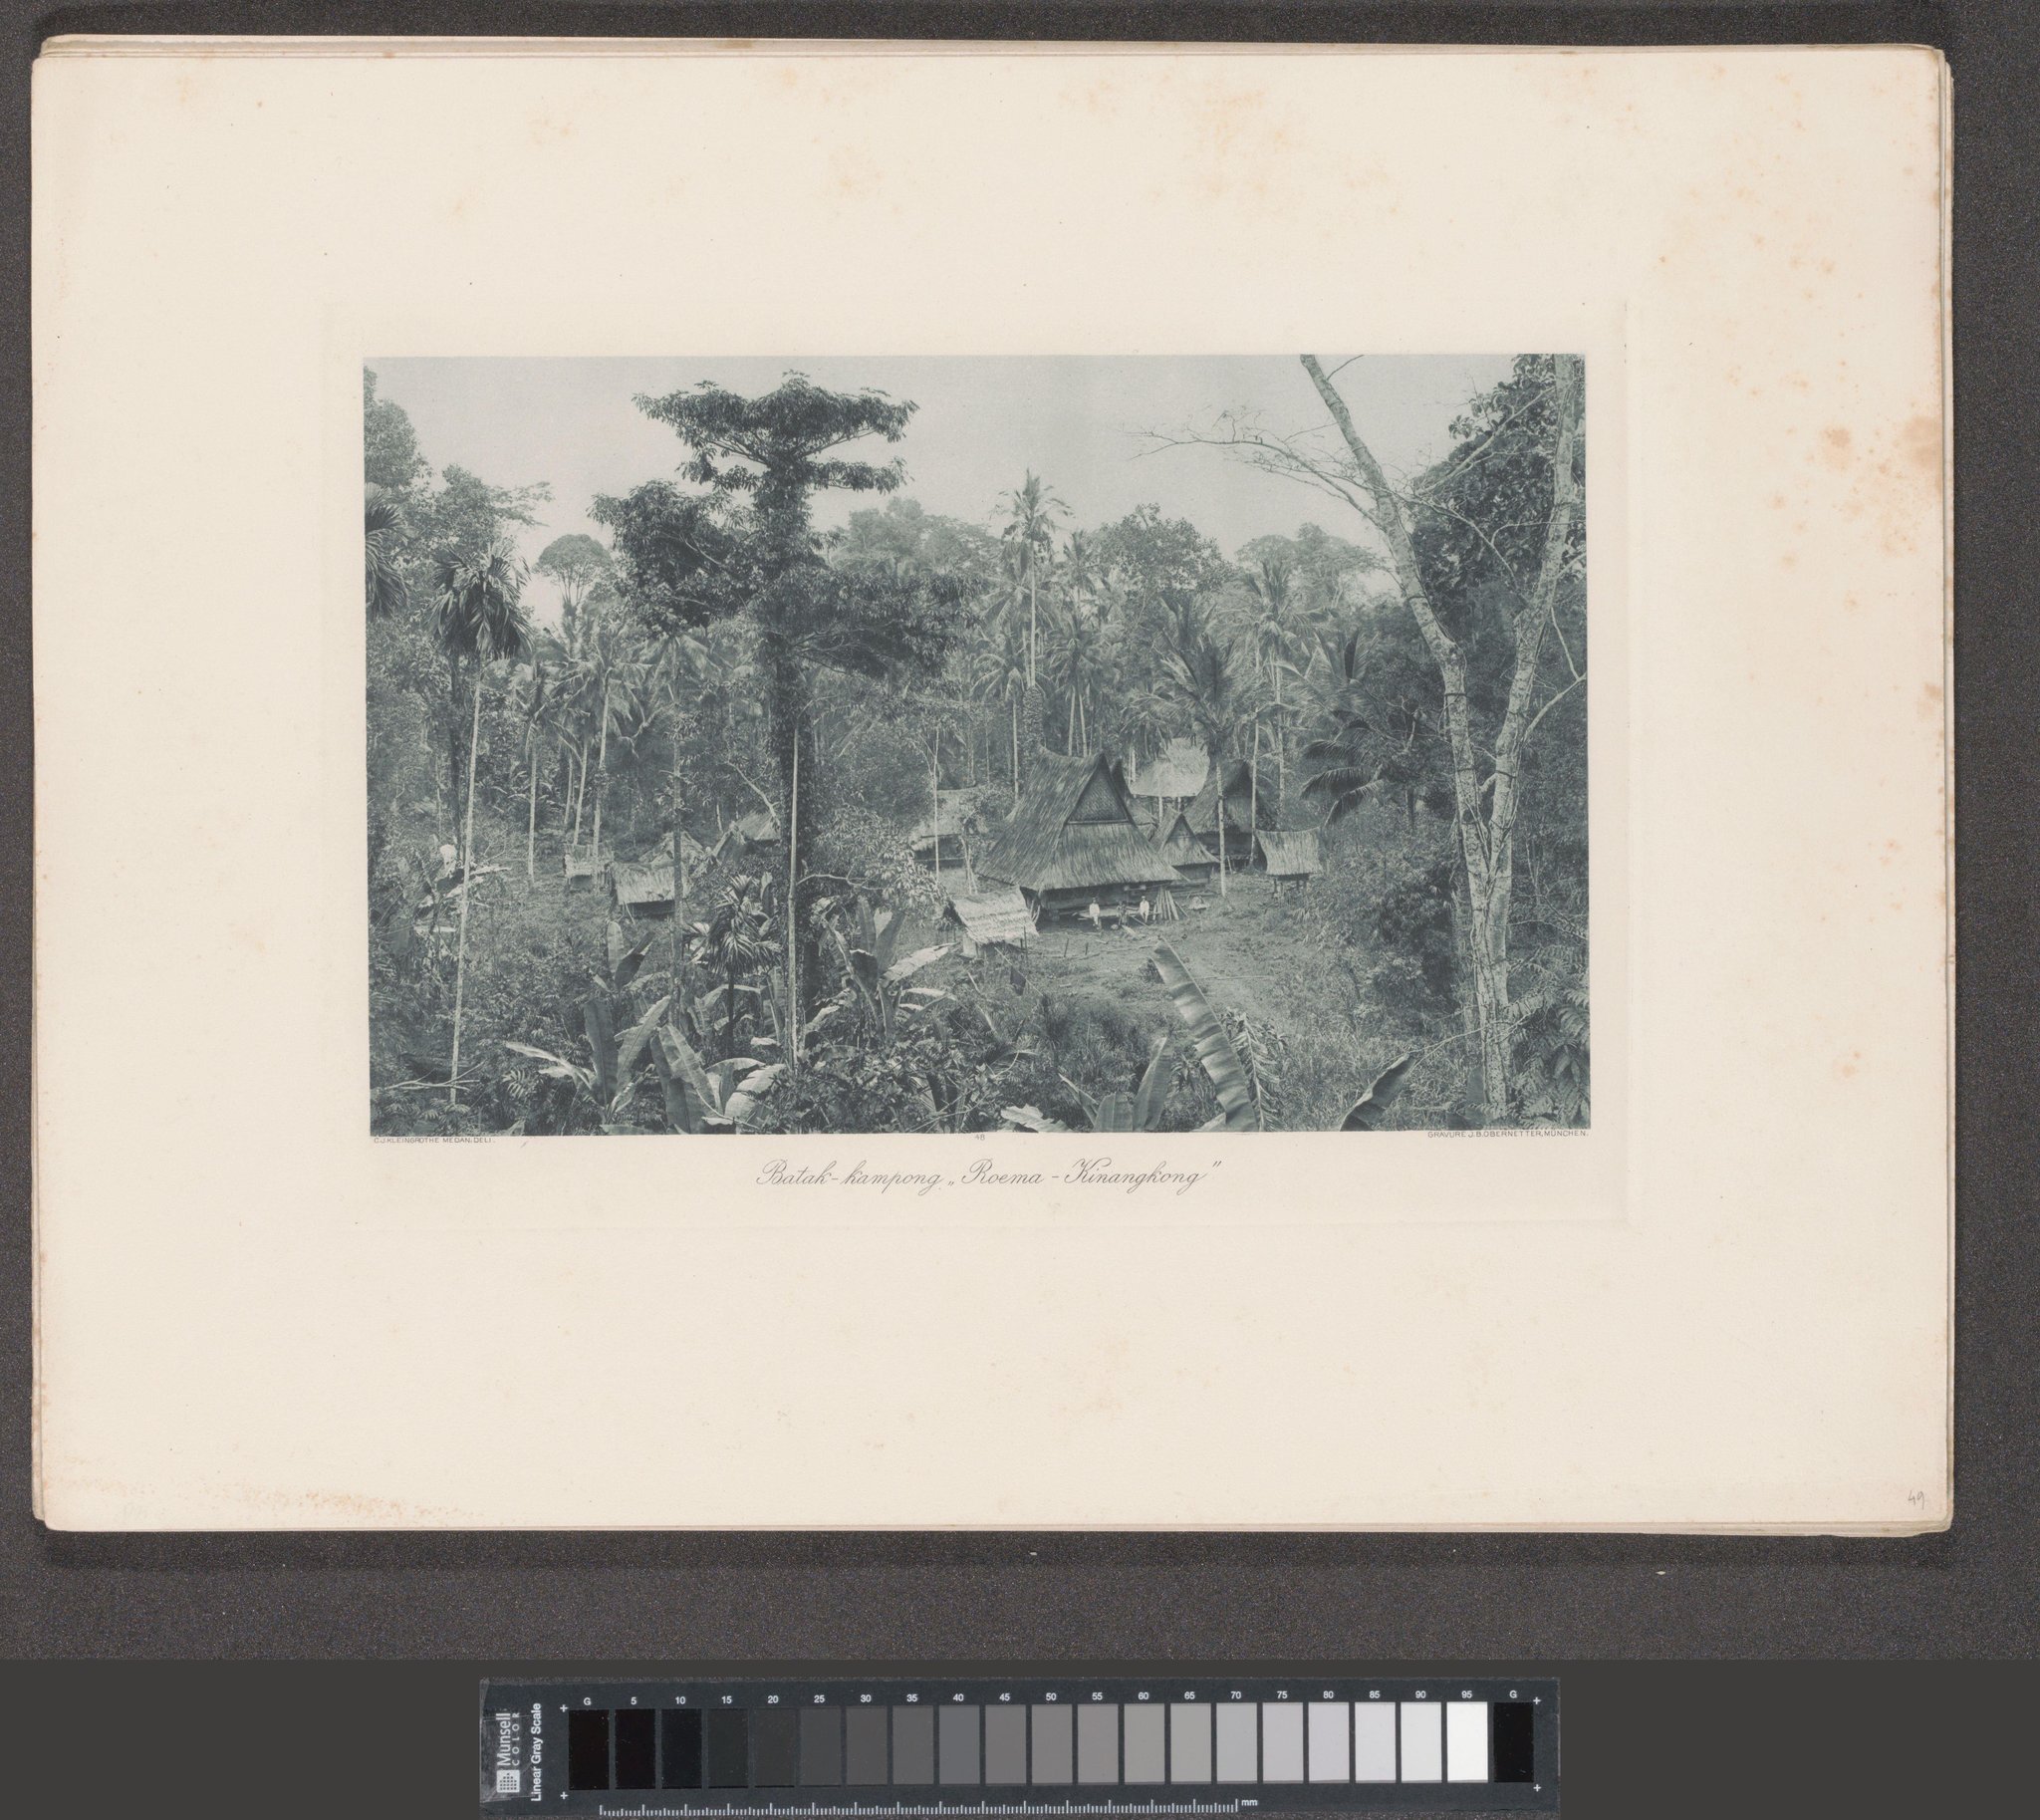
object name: photomechanical print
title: Batak - kampong „Roema - Kinangkong"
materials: paper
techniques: photoaquatint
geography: munich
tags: village, sumatra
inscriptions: number: ‘48’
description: Onderdeel van Album met heliogravures van Sumatra's oostkust.